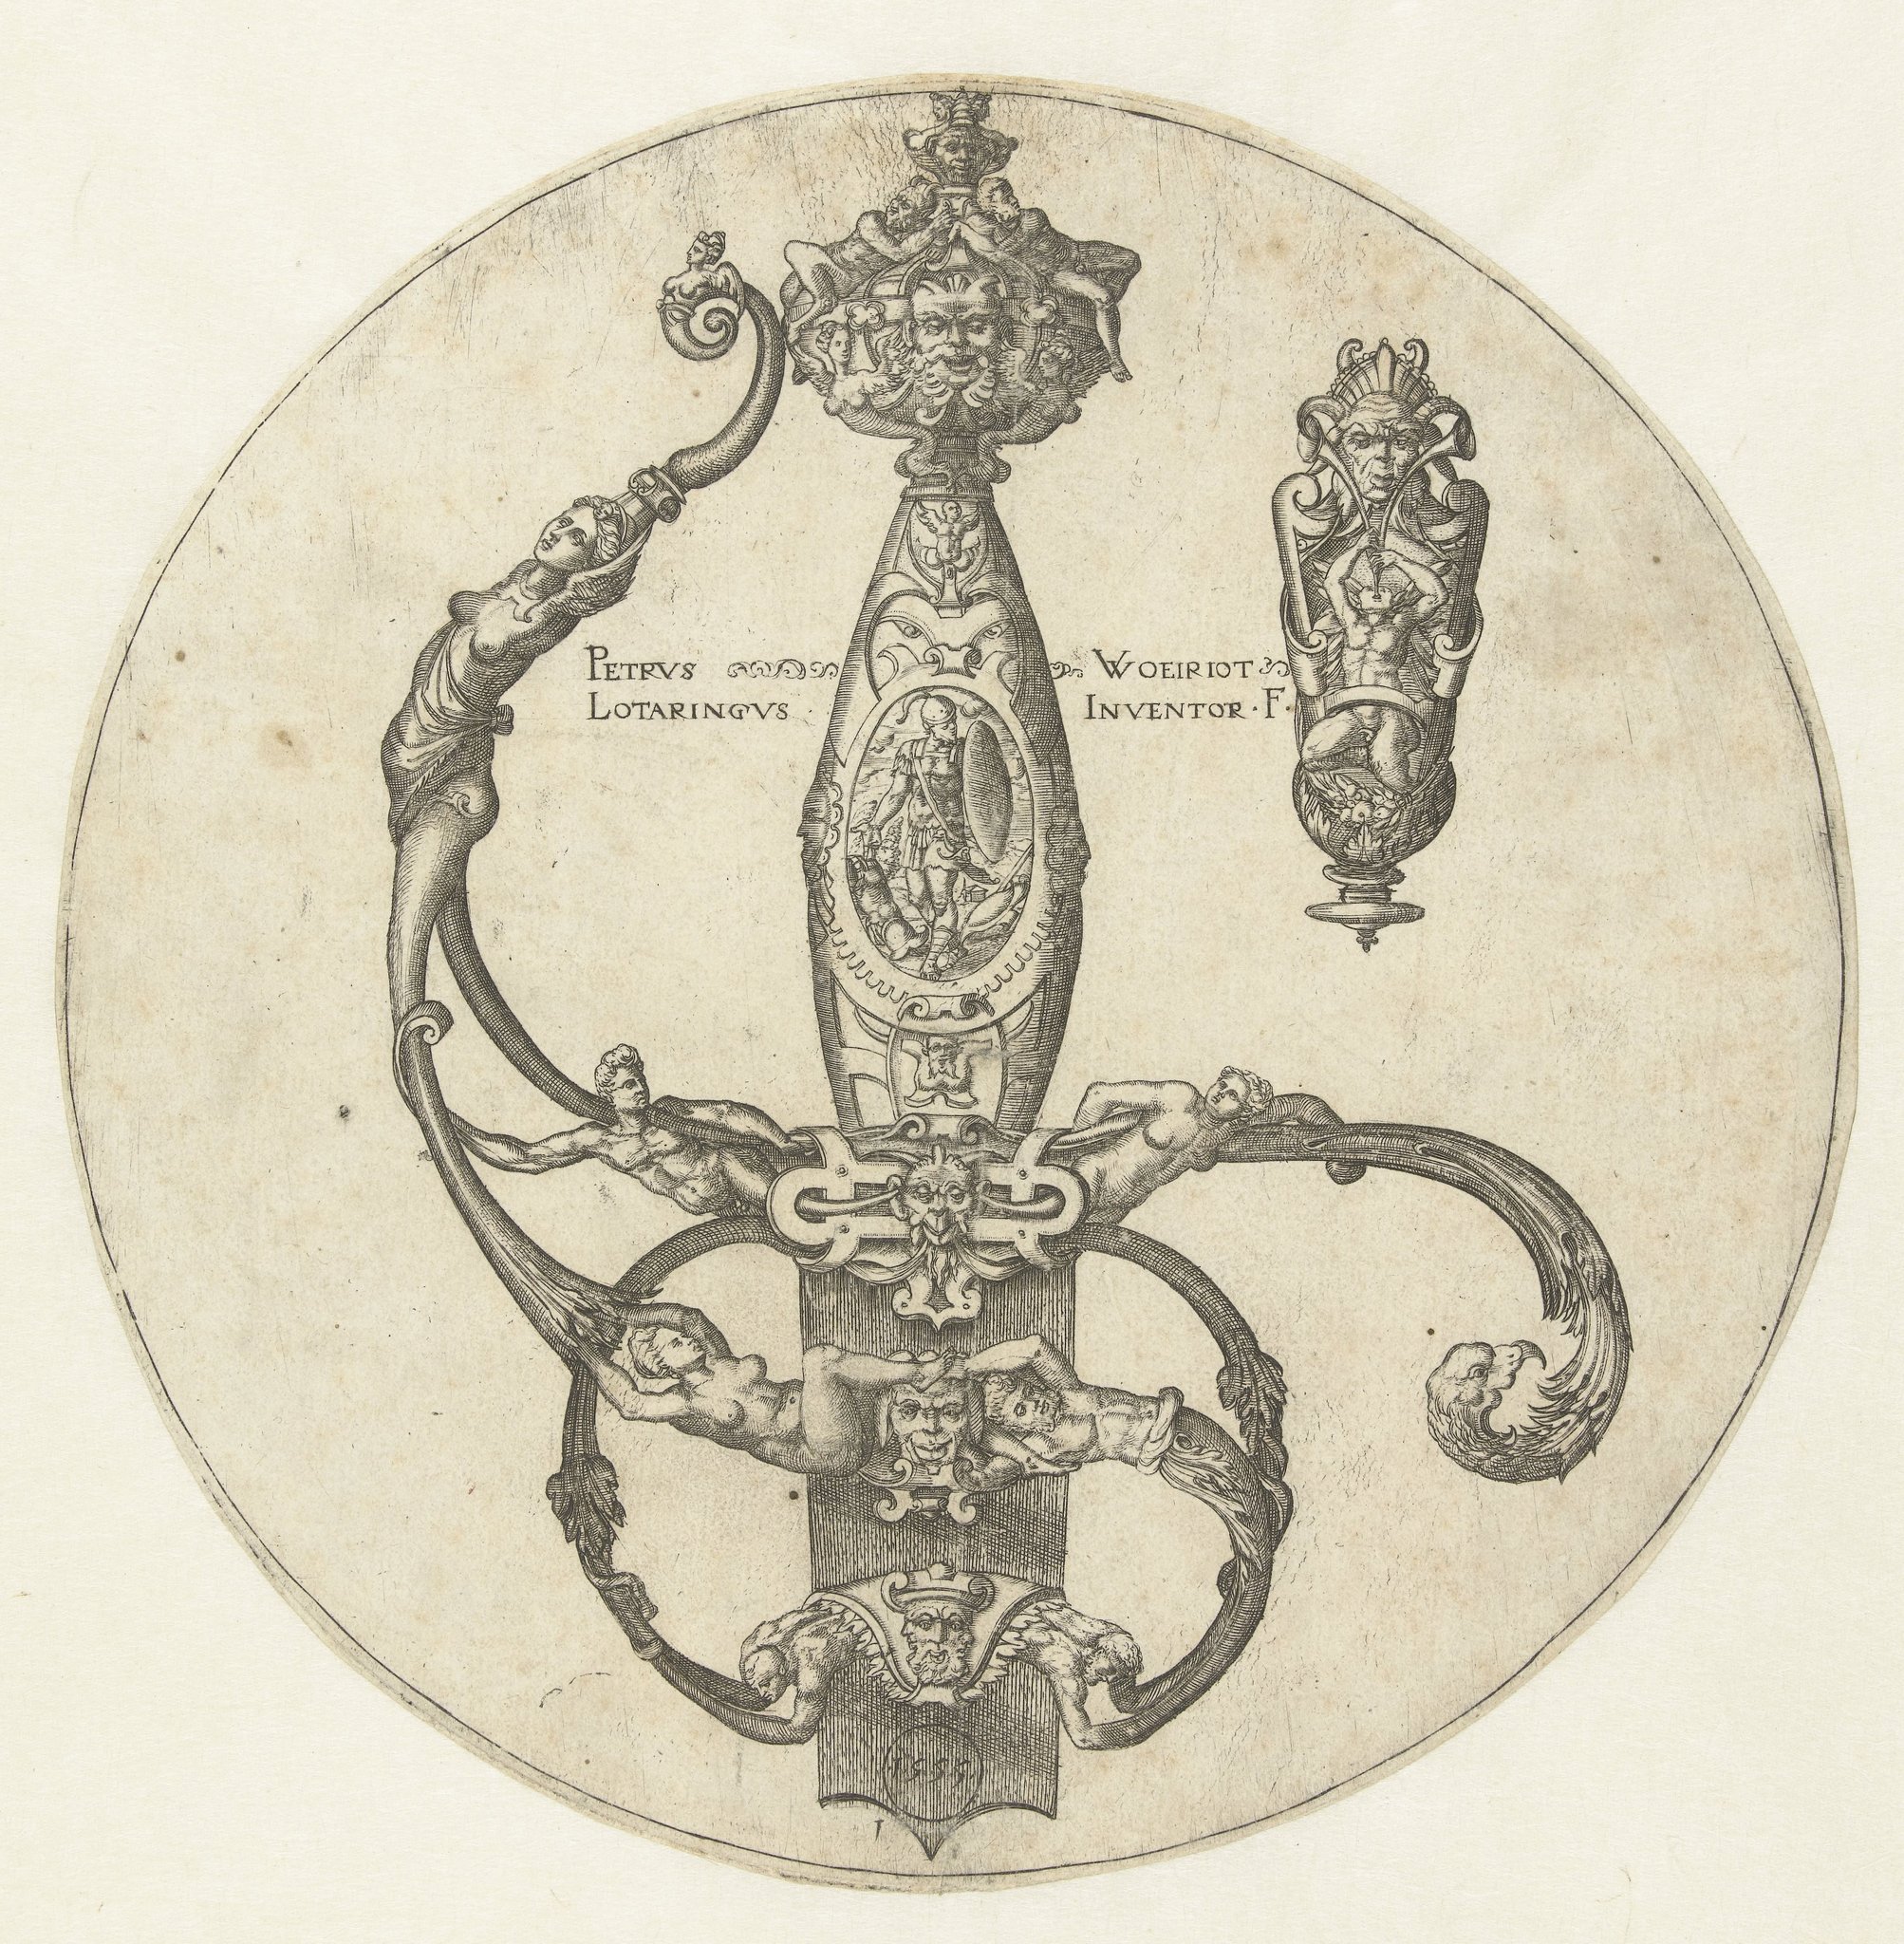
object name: ornament print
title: Ontwerp voor het gevest van een zwaard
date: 1542-1555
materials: paper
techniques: engraving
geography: france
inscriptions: signature: ‘PETRUS WOEIRIOT/LOTHARINGUS INVENTOR. F.’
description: Ontwerp voor het gevest van een zwaard: rond